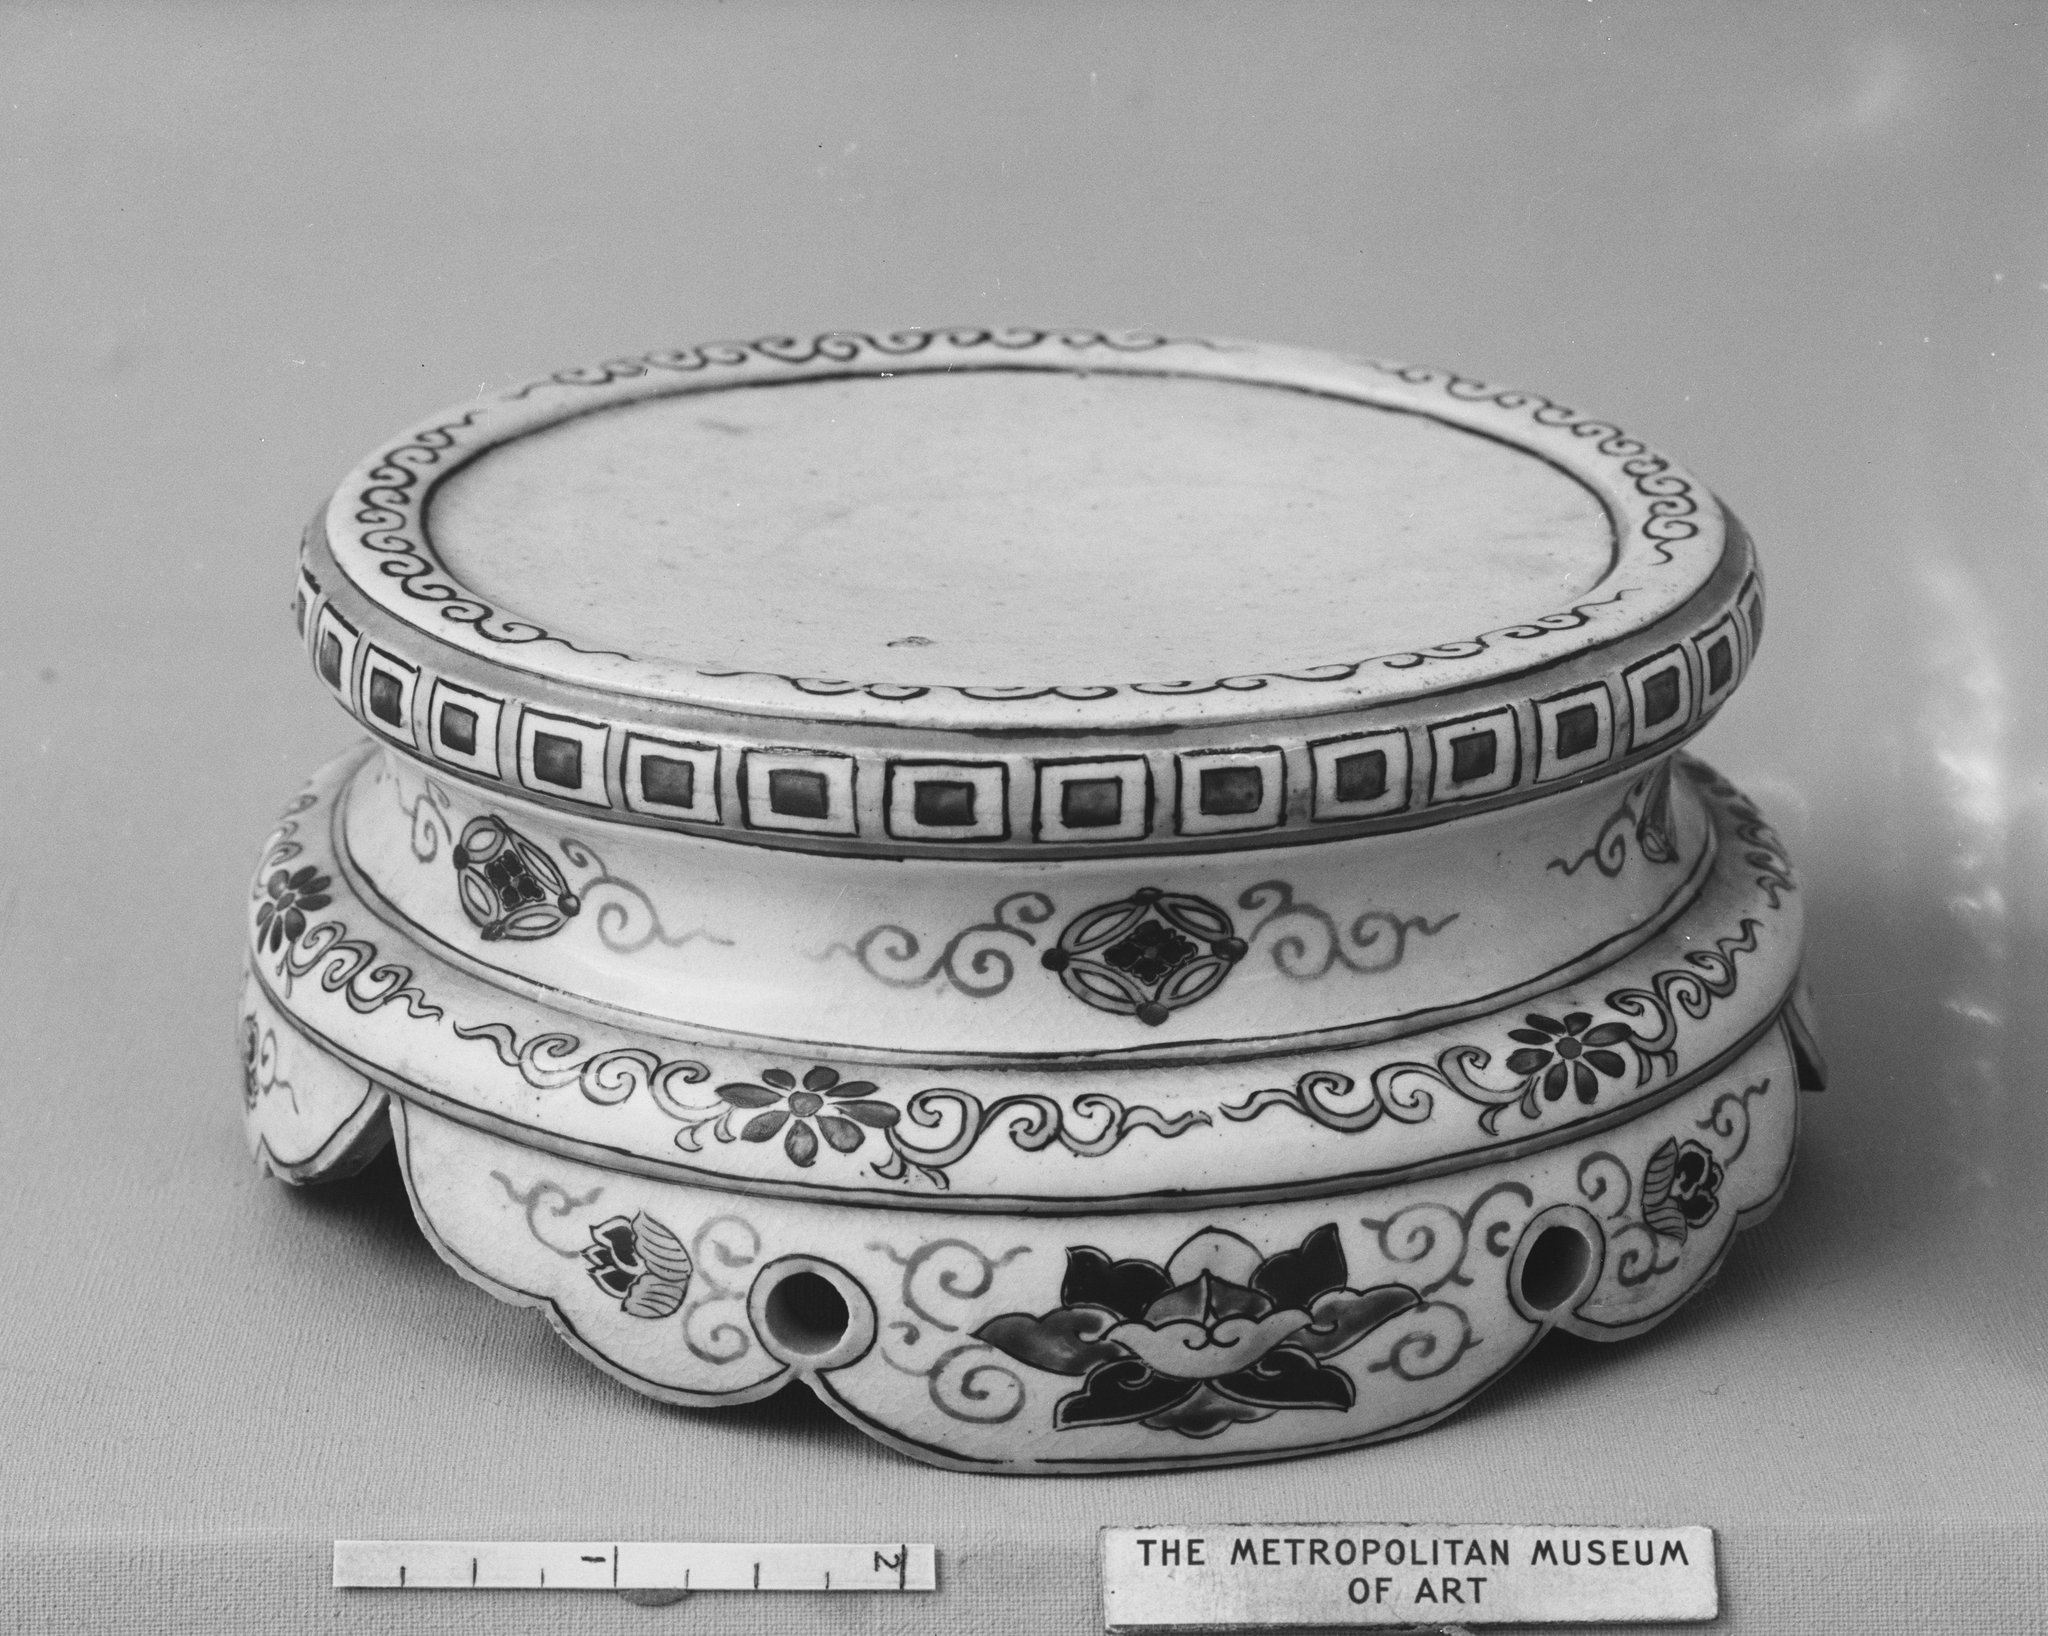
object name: pedestal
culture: japanese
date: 1801-1833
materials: enamel, gold, iron, porcelain